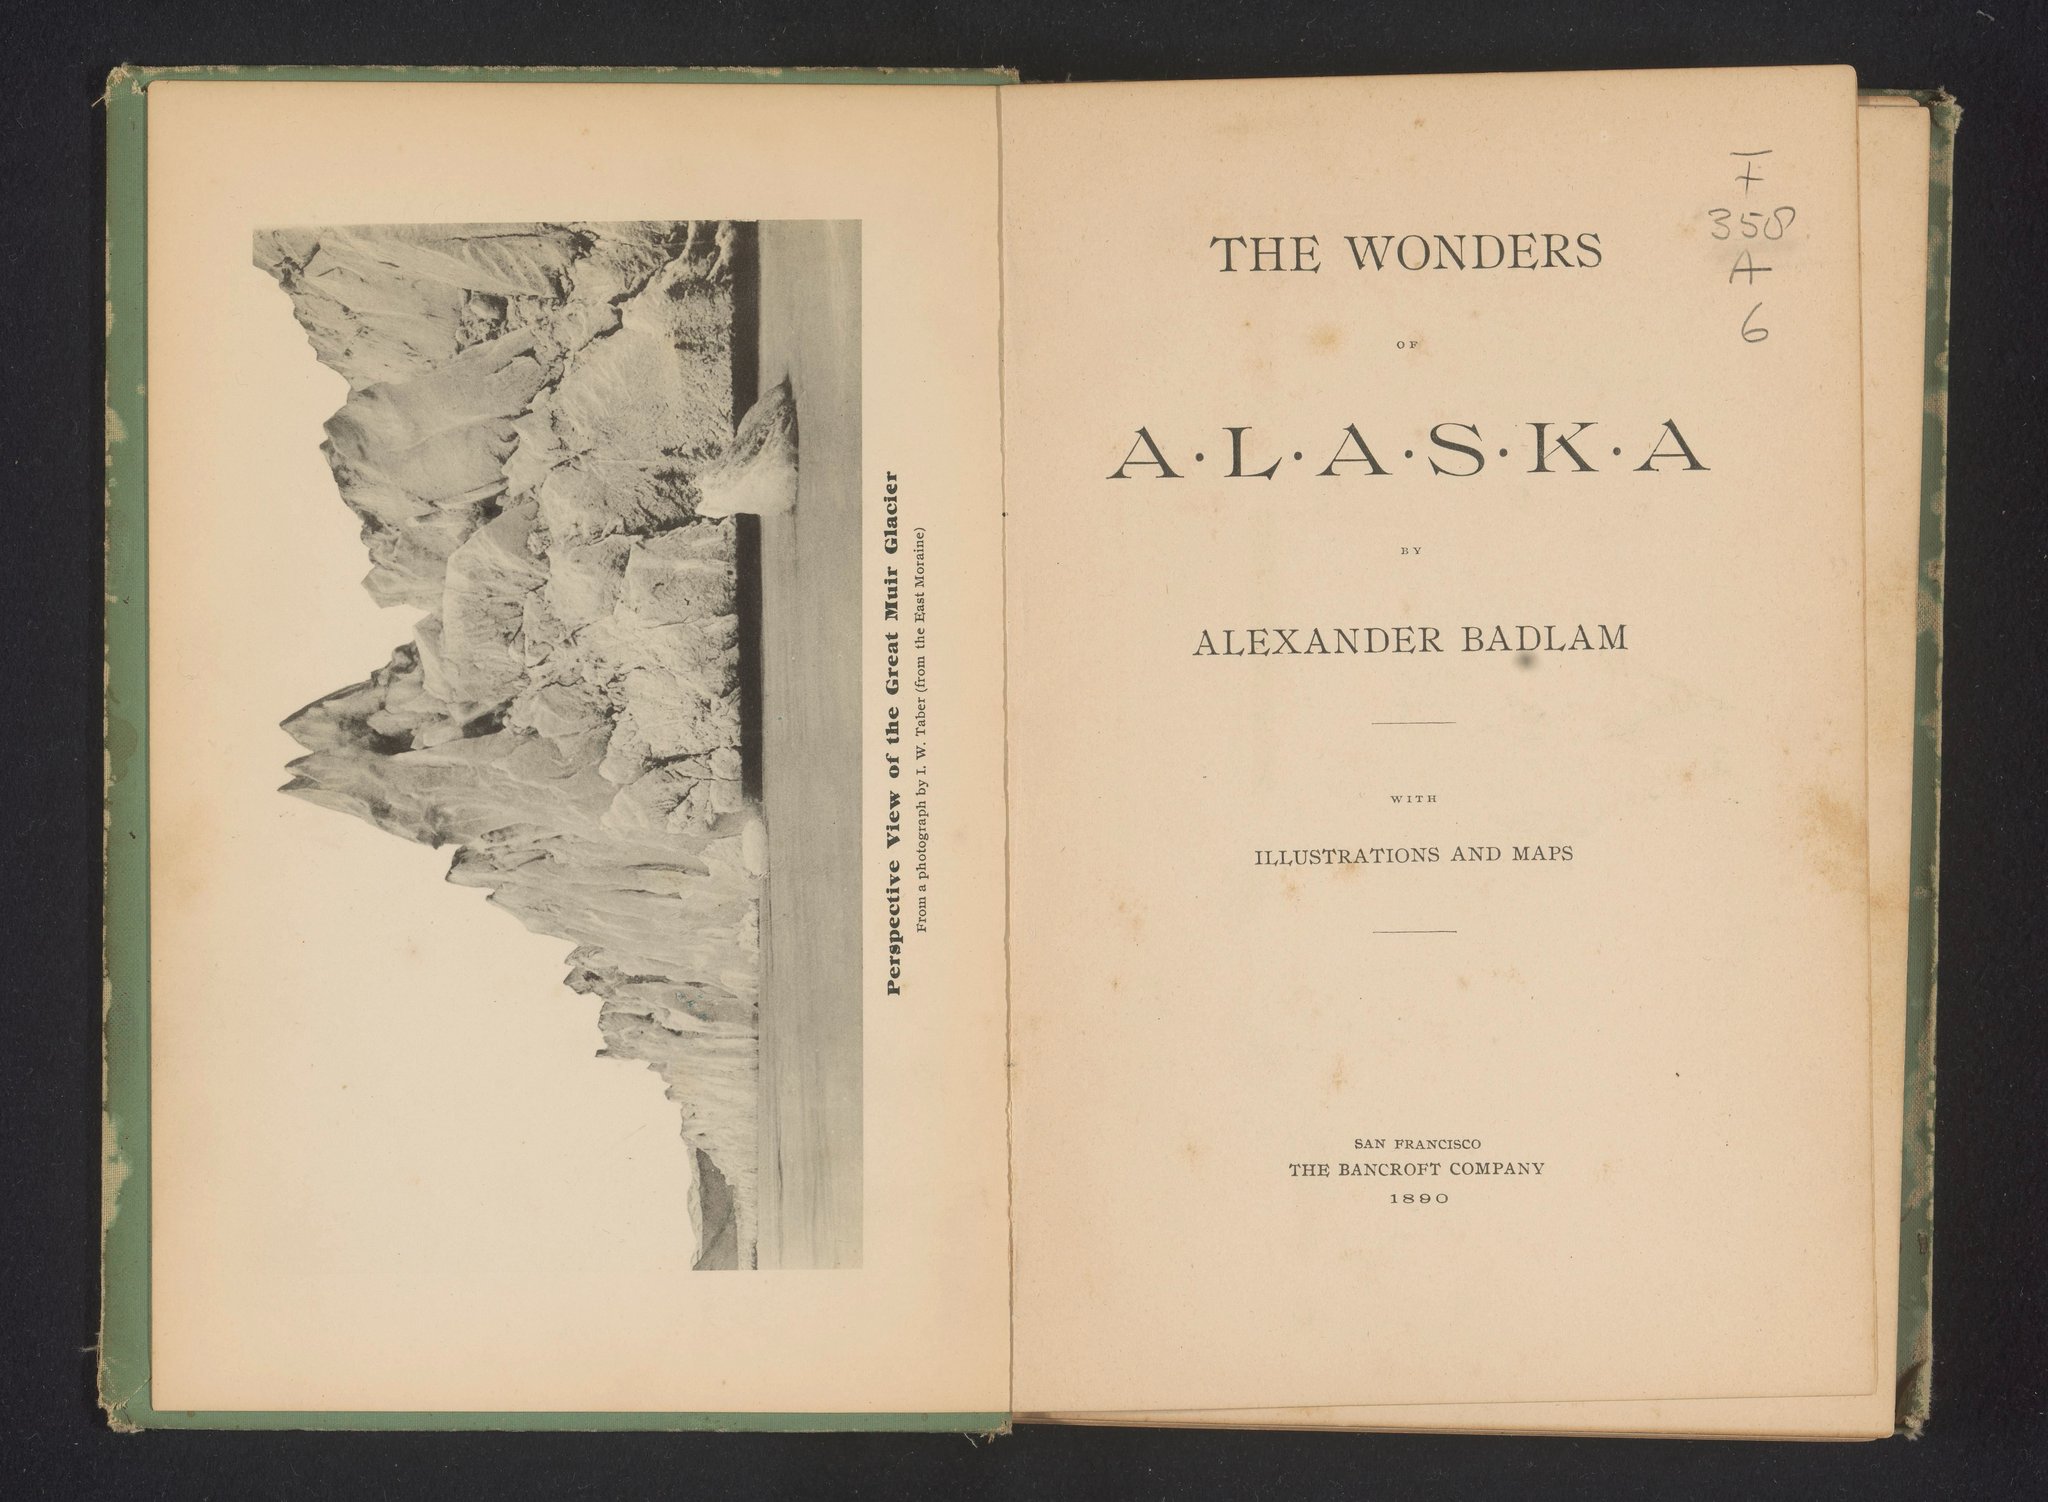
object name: book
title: The wonders of Alaska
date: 1890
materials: linen, paper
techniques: photograph, printing, engraving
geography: san francisco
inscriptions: inscription: ‘In memory of Mr. & Mr.s J.G. Blunt Sr./ Given bij the J.G. Blunt Jr. Family’, date: ‘June 1999’, annotation: ‘al’, collector's mark: ‘CA and Postebens’